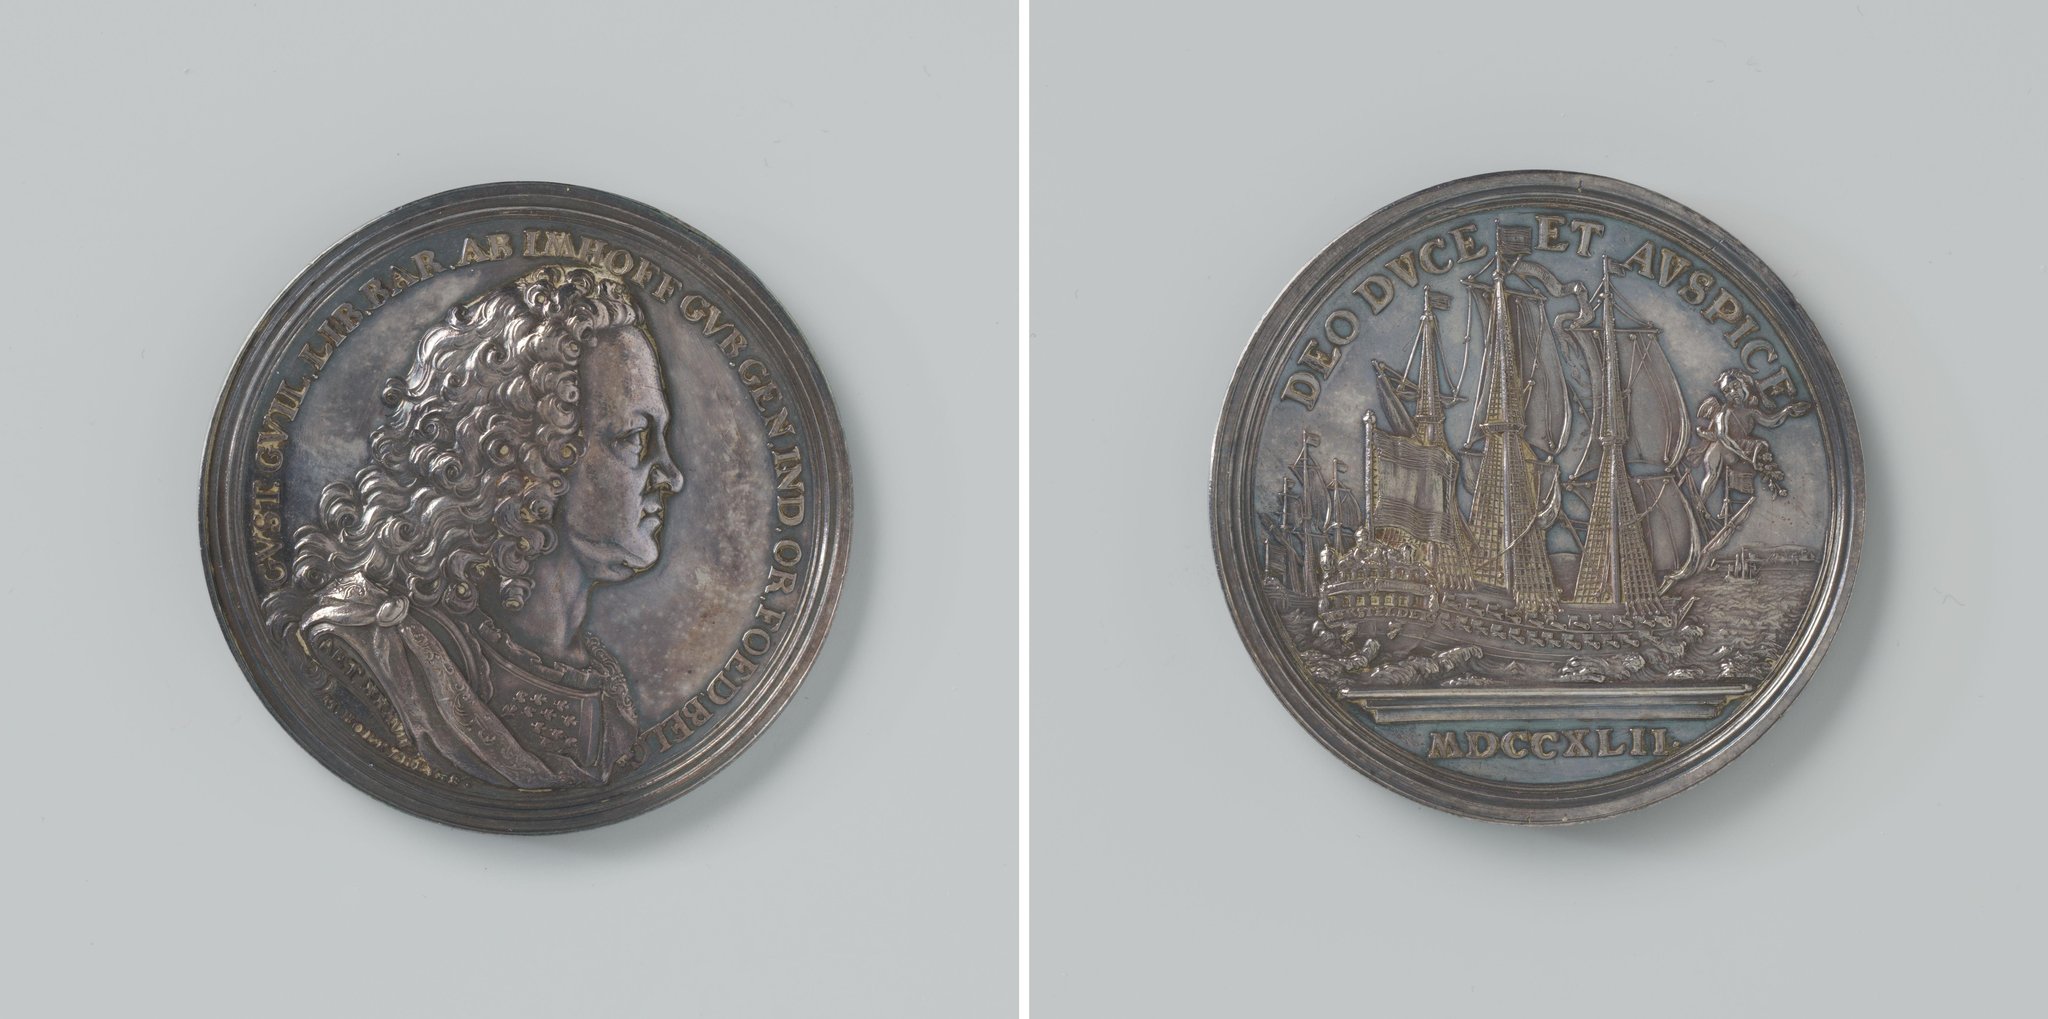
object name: medal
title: Vertrek van Gustaaf Willem, vrijheer van Imhoff, gouverneur-generaal van Nederlands-Indië uit Amsterdam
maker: martinus holtzhey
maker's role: medailleur, muntmaker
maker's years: 1697-1764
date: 1742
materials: silver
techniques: striking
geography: amsterdam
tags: leer (duitsland), gouverneur-generaal, gustaaf willem baron van imhoff (1705-1750)